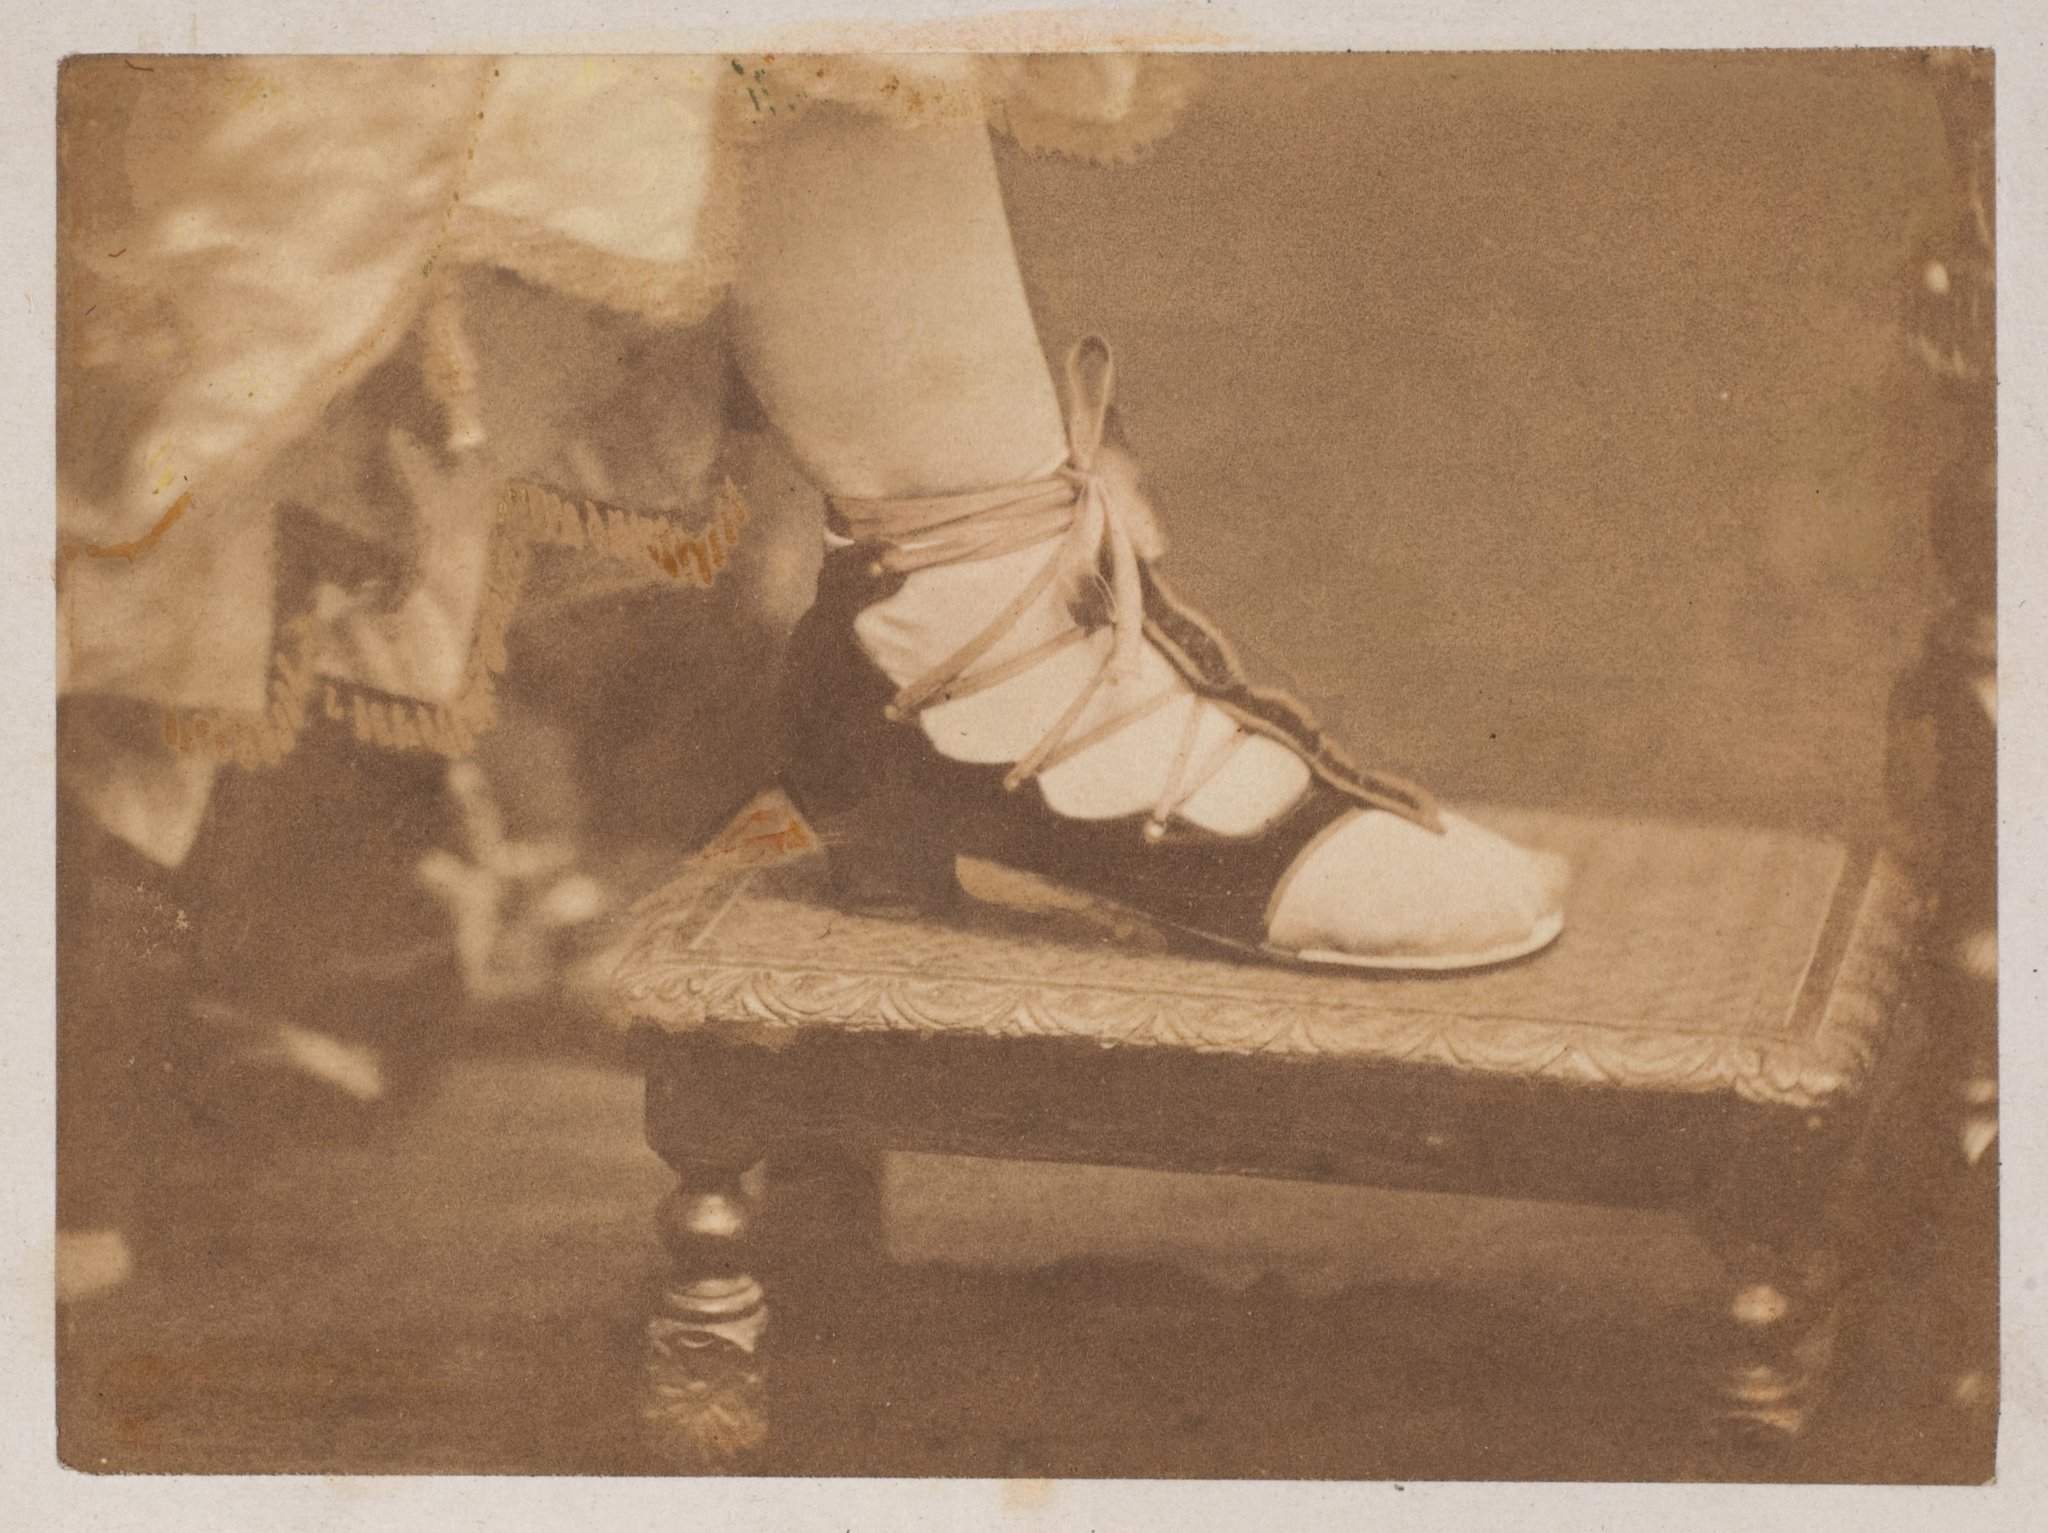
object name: photograph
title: Piede de Judith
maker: pierre-louis pierson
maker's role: artist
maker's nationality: french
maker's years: 1822-1913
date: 1860-1869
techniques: albumen silver print, glass negative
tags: shoes,feet